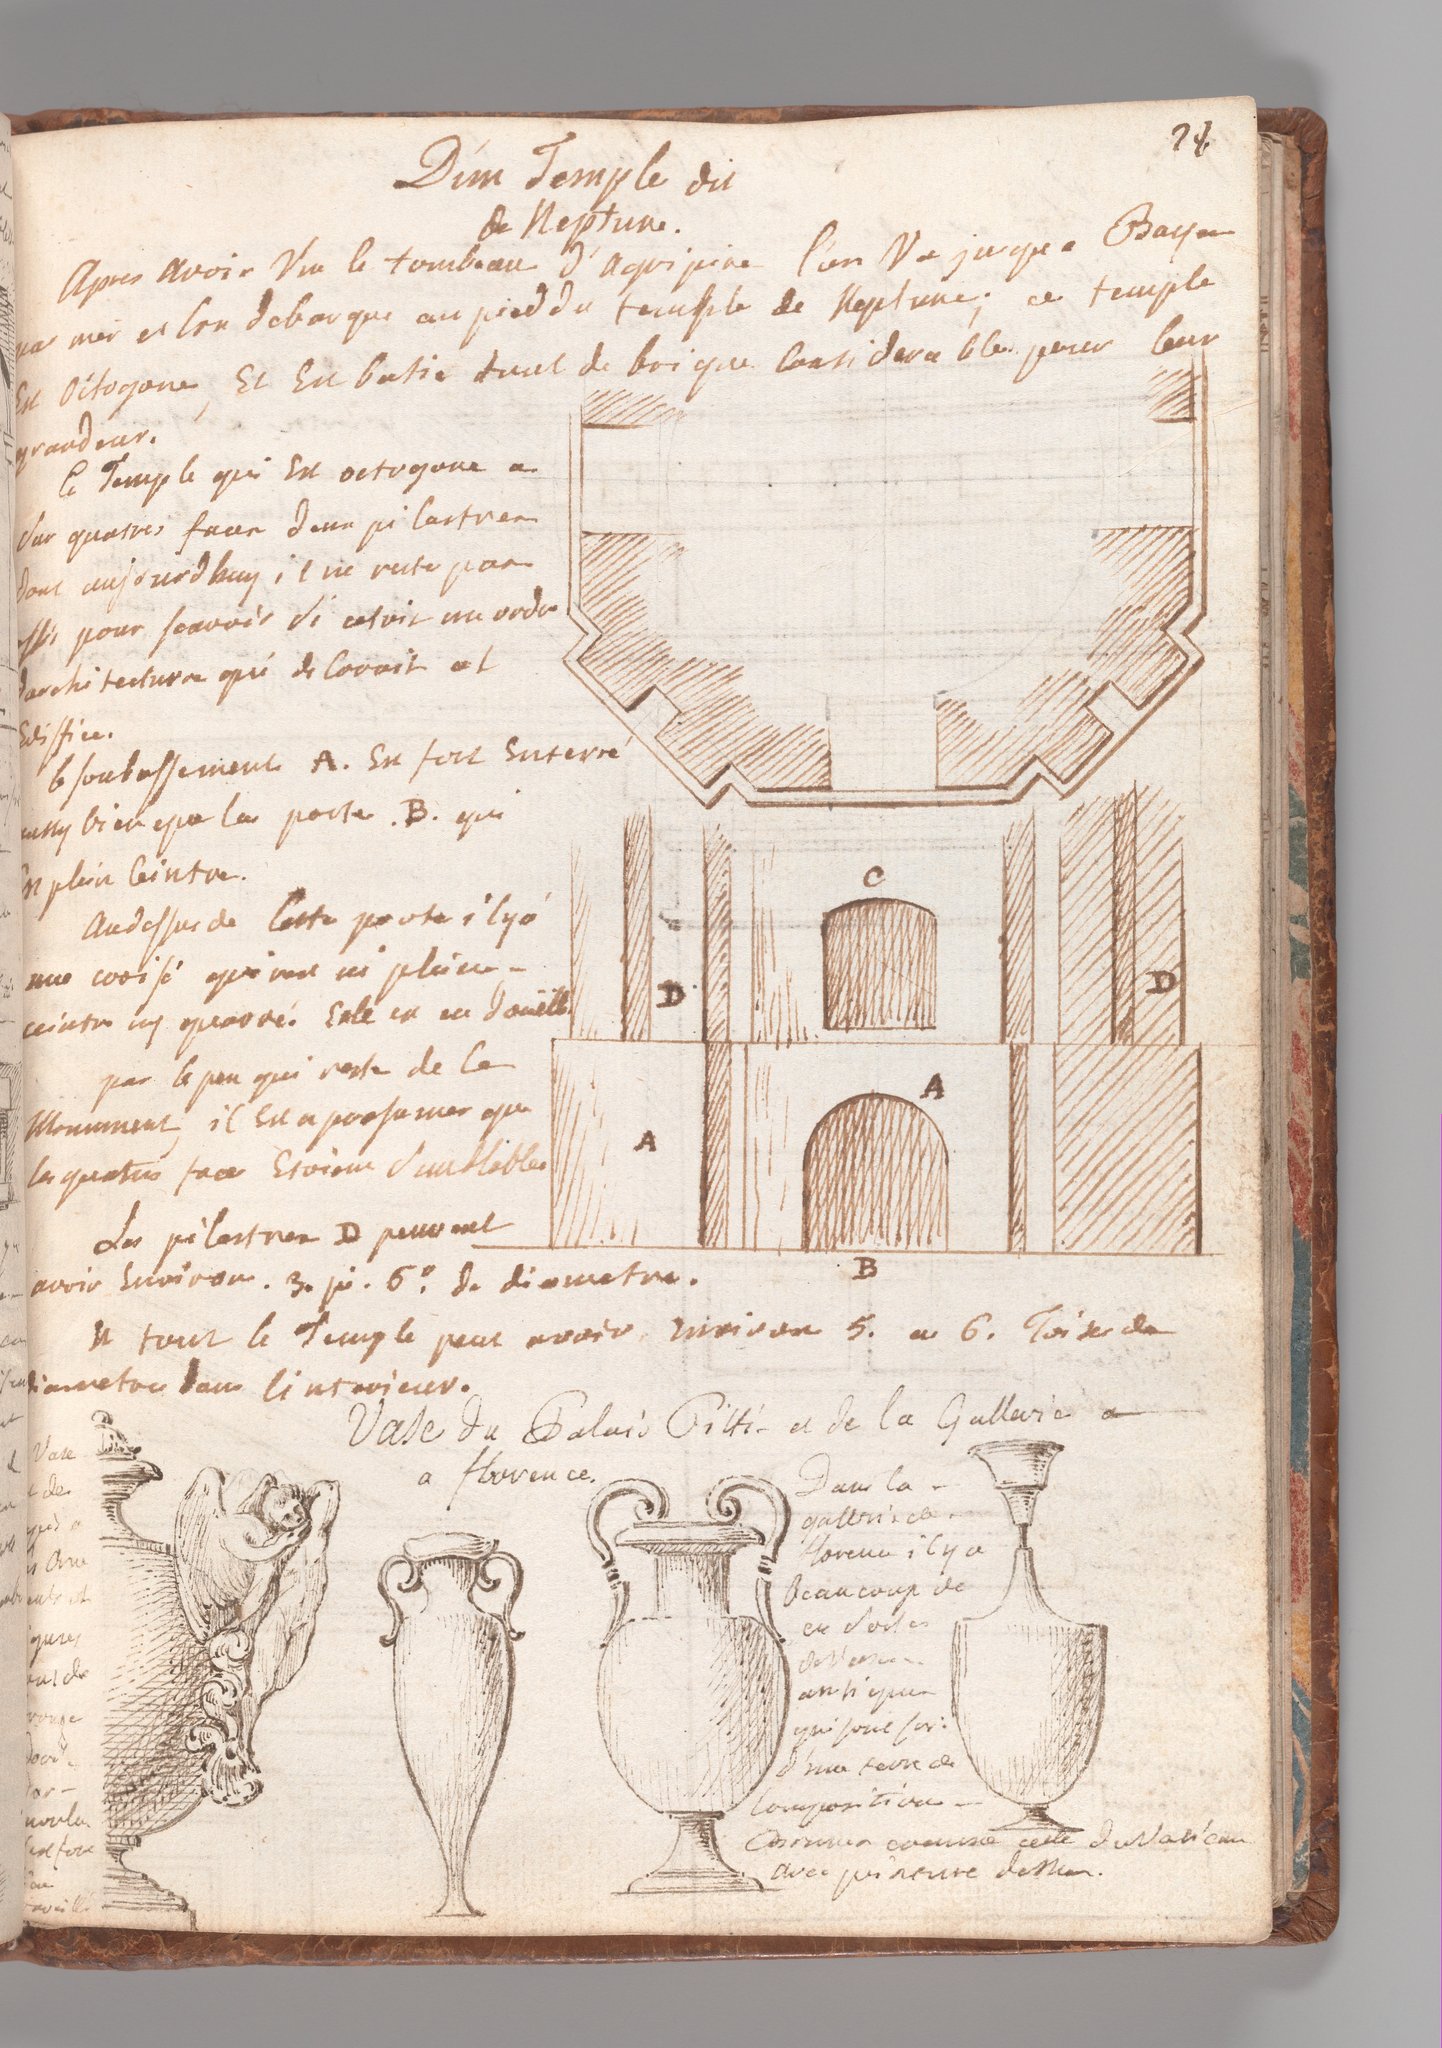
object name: album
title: Notebook with Views of the Excavations at Herculaneum and of Other Italian Cities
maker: jérôme charles bellicard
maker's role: artist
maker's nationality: french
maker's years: 1726-1786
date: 1750-1751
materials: leather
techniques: bookbinding